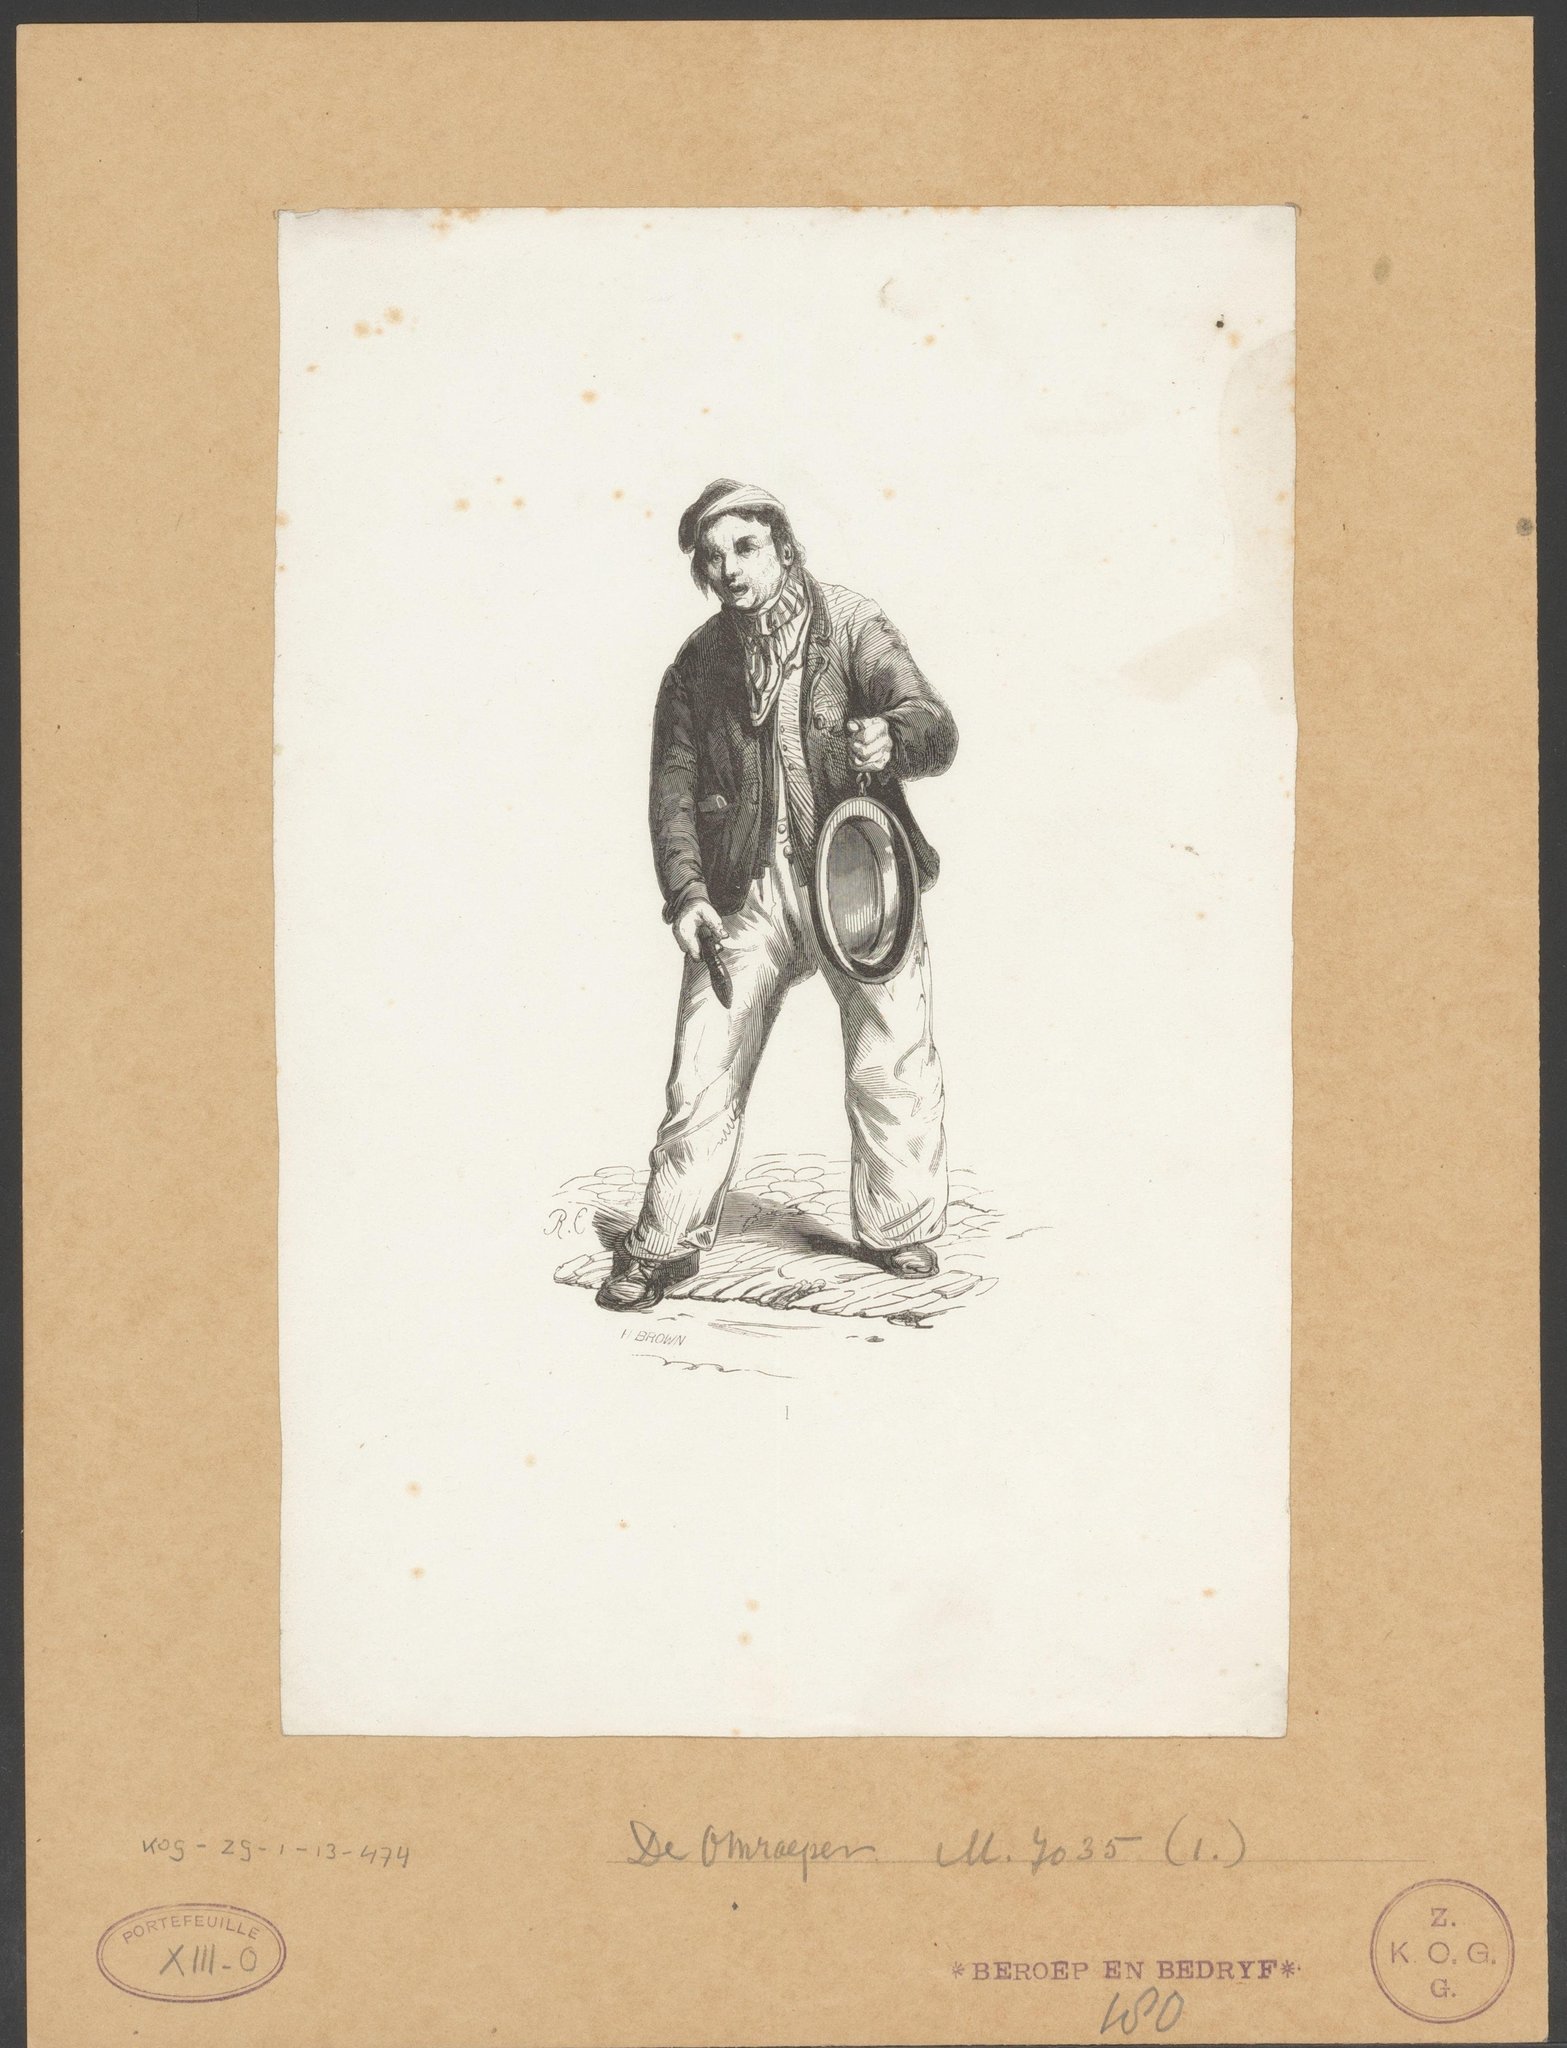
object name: print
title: De omroeper, 1840-1841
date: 1840-1841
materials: paper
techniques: engraving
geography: haarlem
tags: professional clothes, oral spreading of news, town crier, netherlands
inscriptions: stamp, stamp, collector's mark: Lugt 1641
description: Staande omroeper met bekken en stok om er mee op te slaan. Los exemplaar van een illustratie uit een boek met karakterschetsen, beroepen en klederdrachten van Nederlandse volkstypen uit 1841. Onderwerpsrubrieken binnen de Atlas Zeden en Gewoonten: Handel, Nijverheid en verkeer, Beroep en bedrijf, Mannelijk, Klapperman, omroeper, nachtwaker.